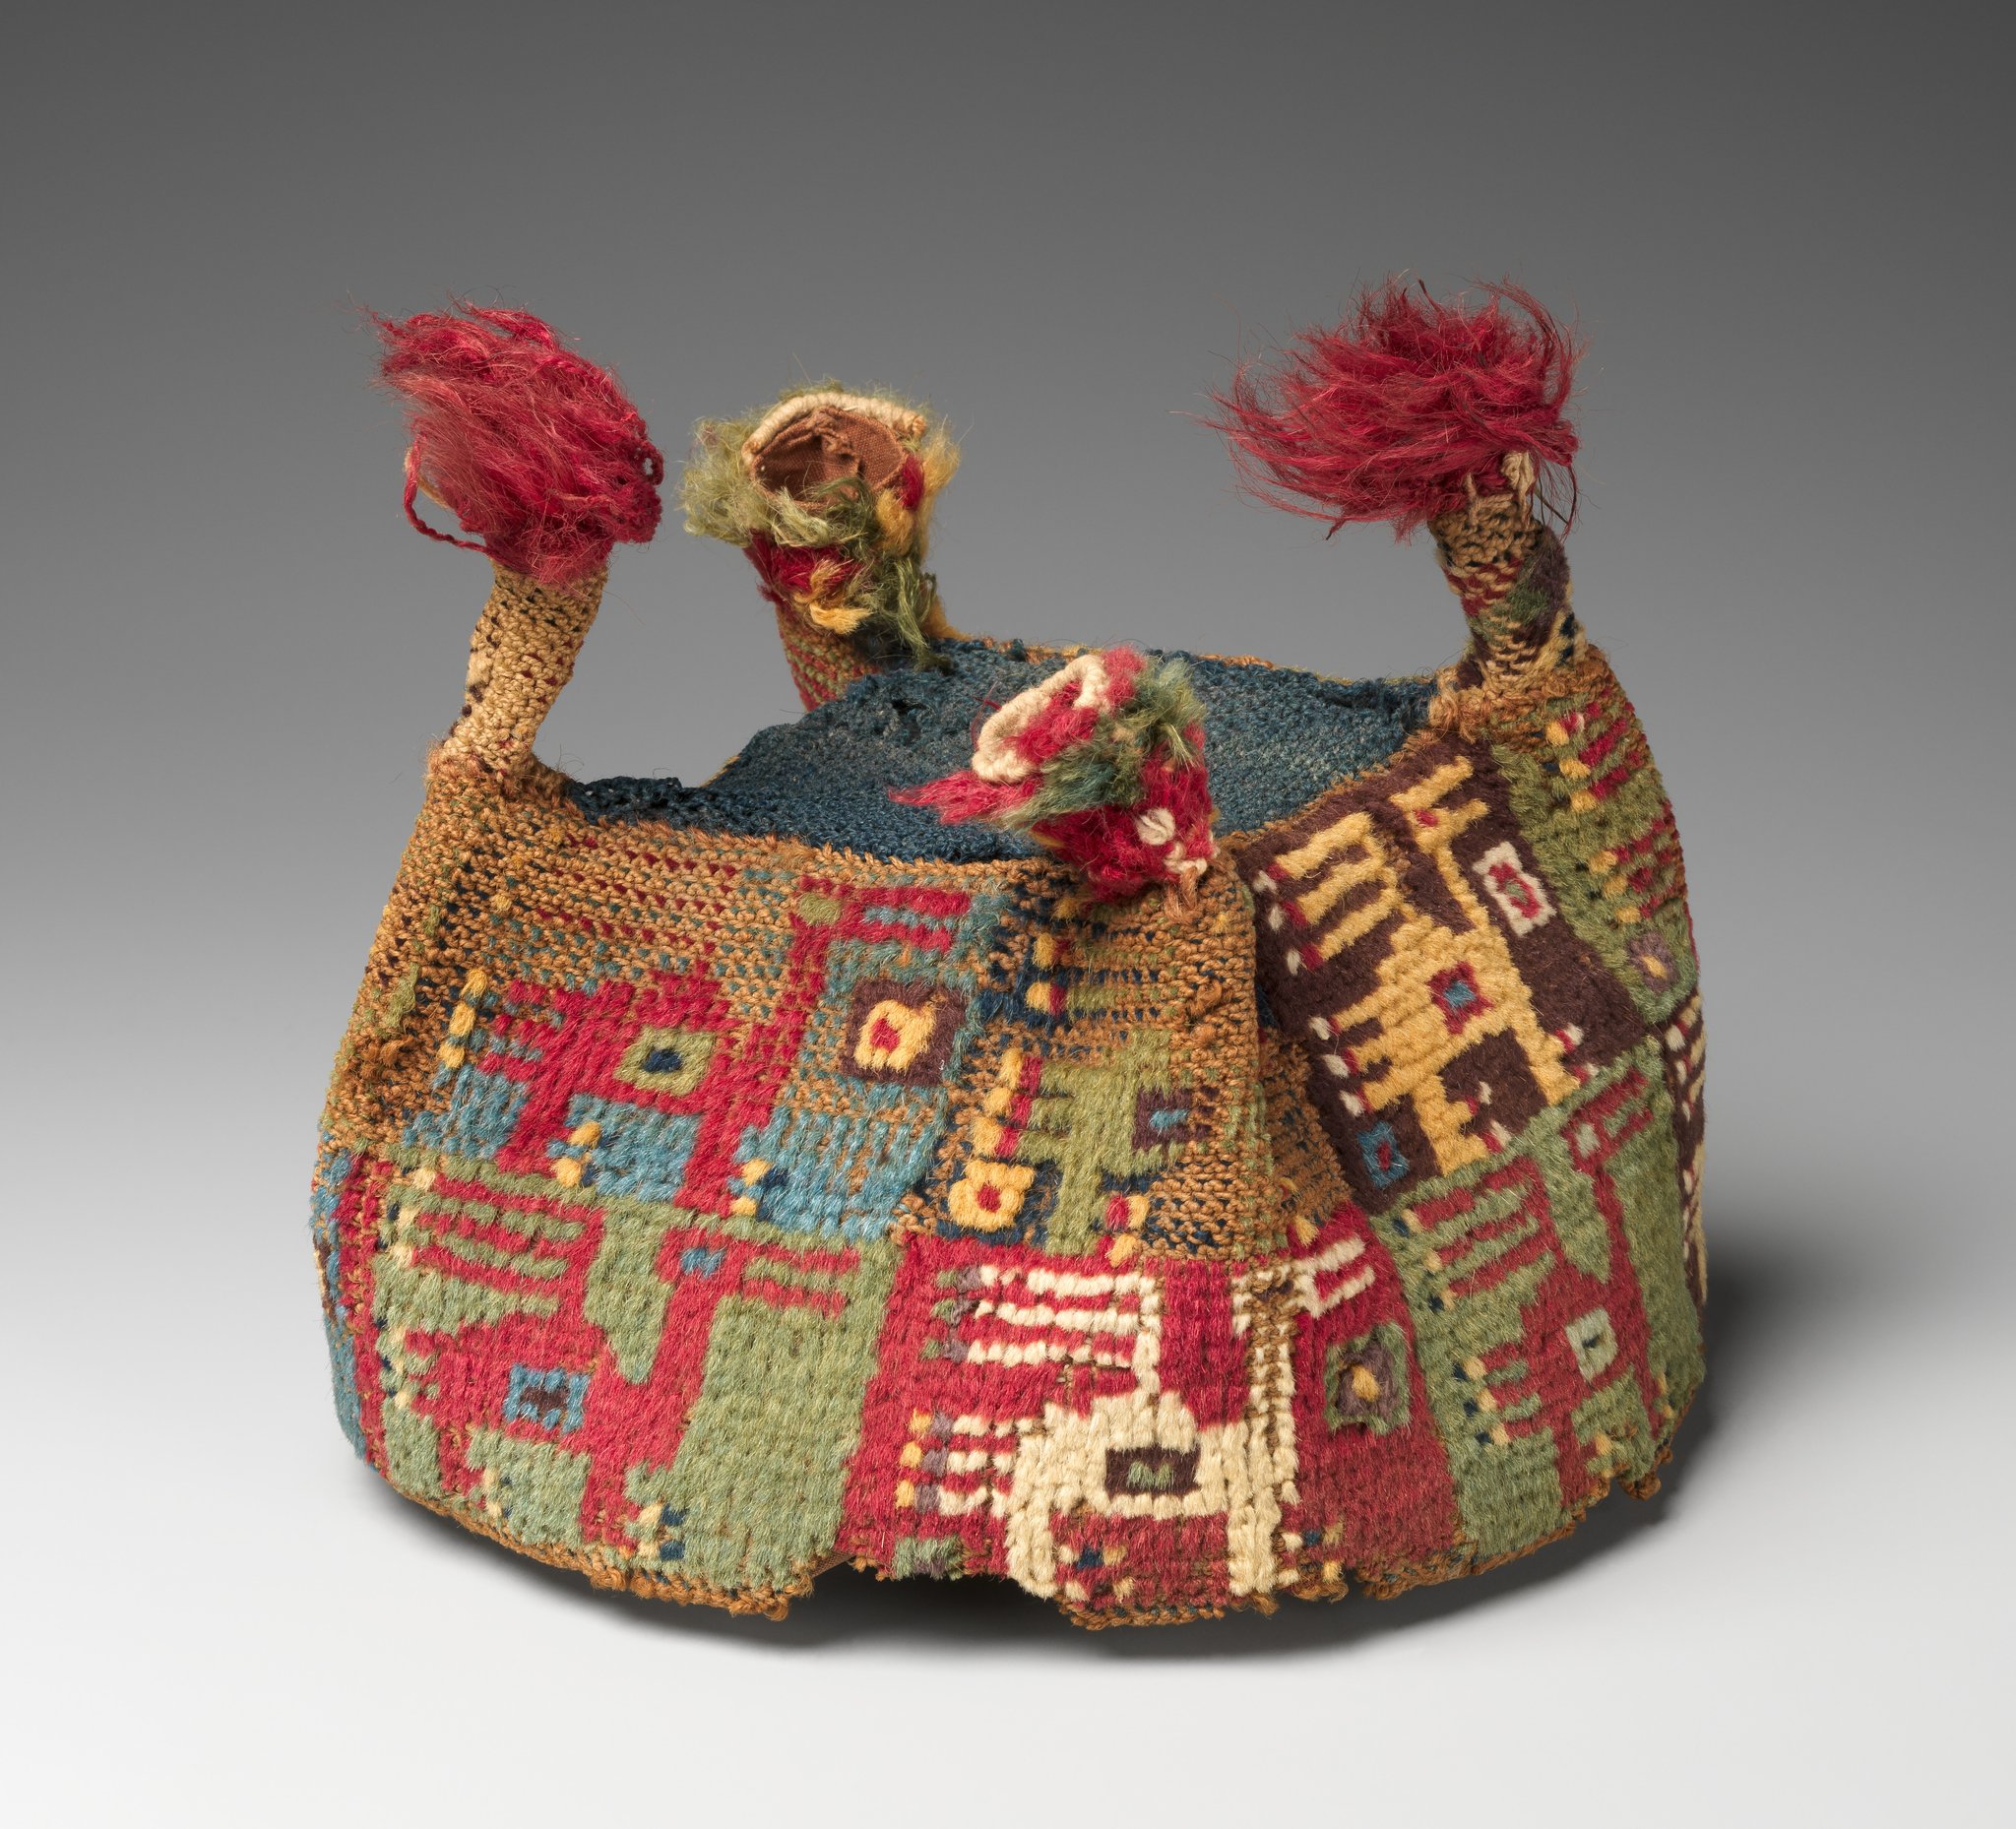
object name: hat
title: Four-Cornered Hat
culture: wari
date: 601-900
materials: animal fiber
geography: peru